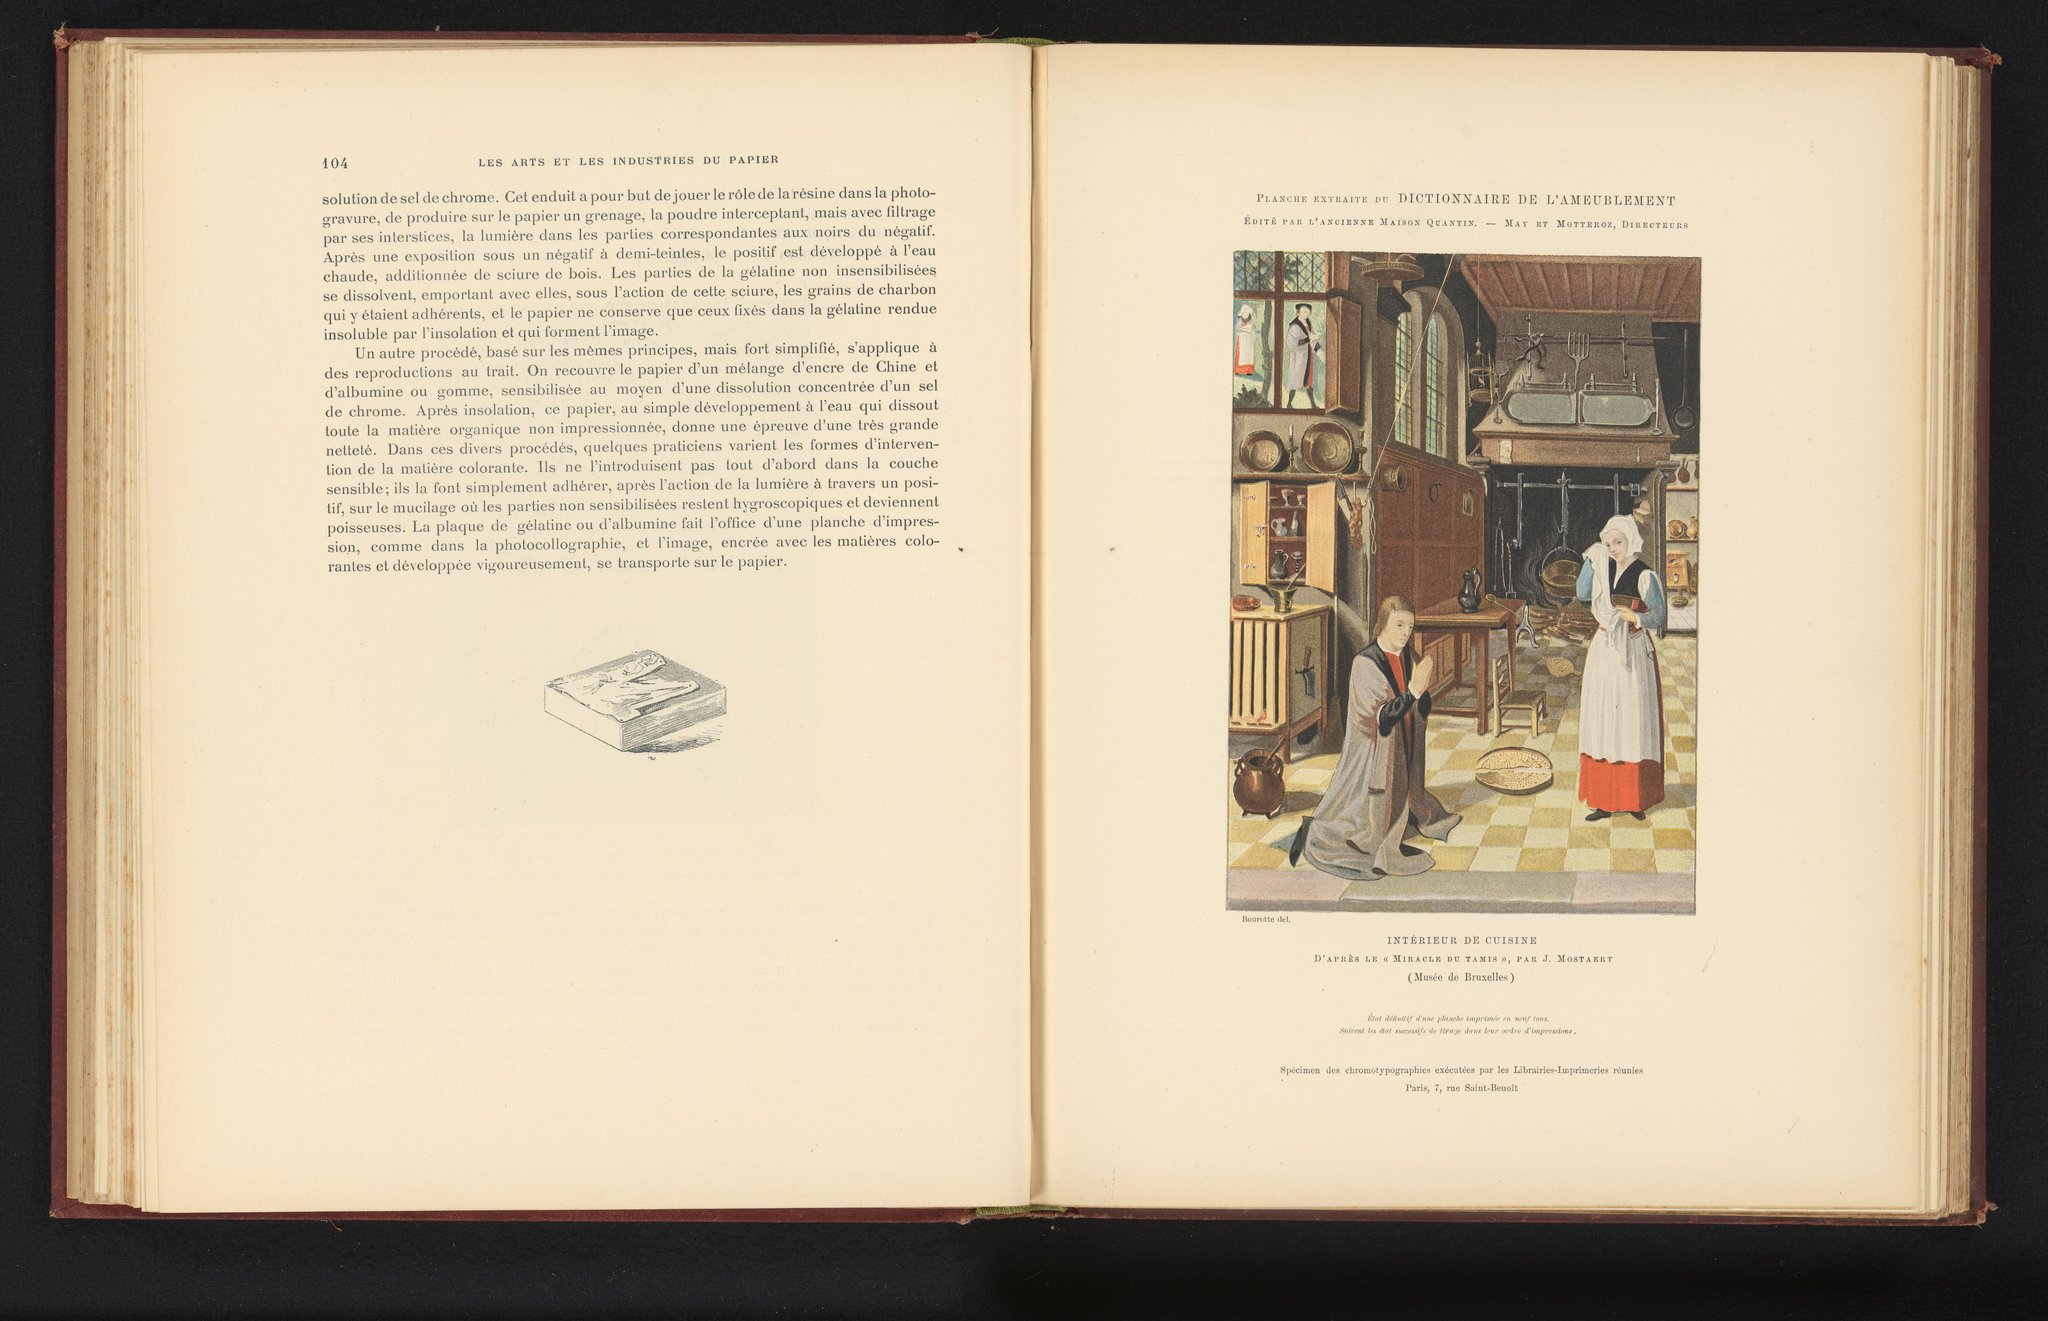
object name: print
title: Reproductie van het schilderij Het mirakel van de gebroken zeef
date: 1889-1894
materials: paper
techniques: chromolithography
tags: kitchen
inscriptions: inscription: ‘D'après le Miracle du Tamis, par J. Mostaert (Musée de Bruxelles)’, inscription: ‘Bourotte del.’, inscription: ‘Planche extraite du Dictionnaire de l'Ameublement/ Édité par l'ancienne Maison Quantin. - May et motteroz, Directeurs’, inscription: ‘État définitif d'une planche imprimé en neuf tons. Suivent les état successifs de tirage dans leur ordre d'impressions’